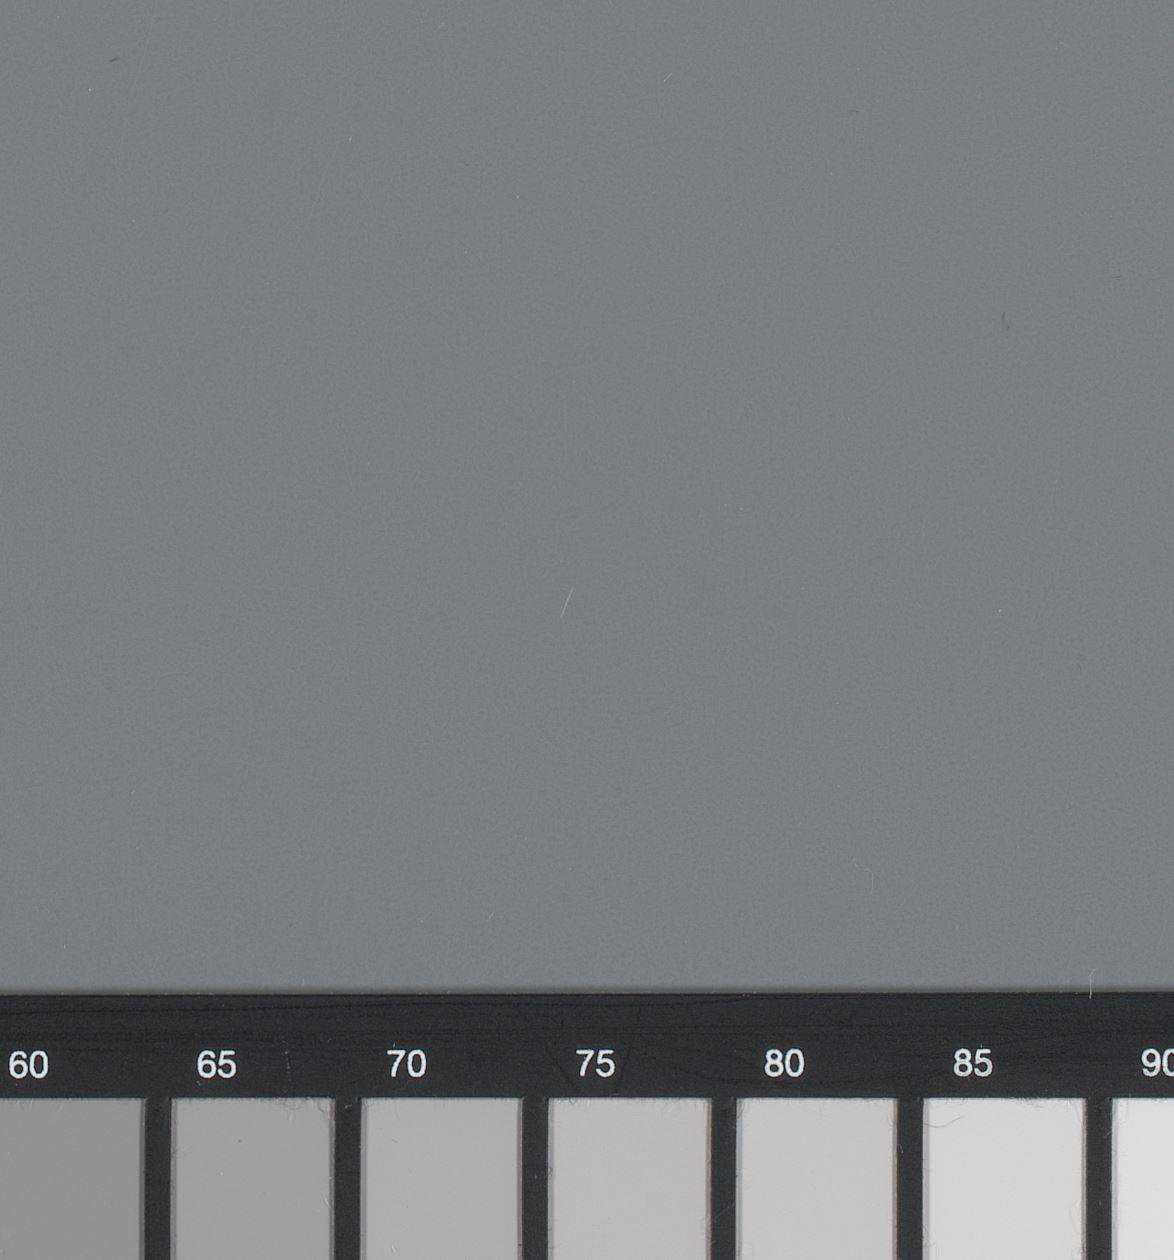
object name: photograph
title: Miniatuurportret van een onbekende vrouw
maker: Anonymous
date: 1890-1910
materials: paper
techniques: gelatin silver print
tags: adult woman